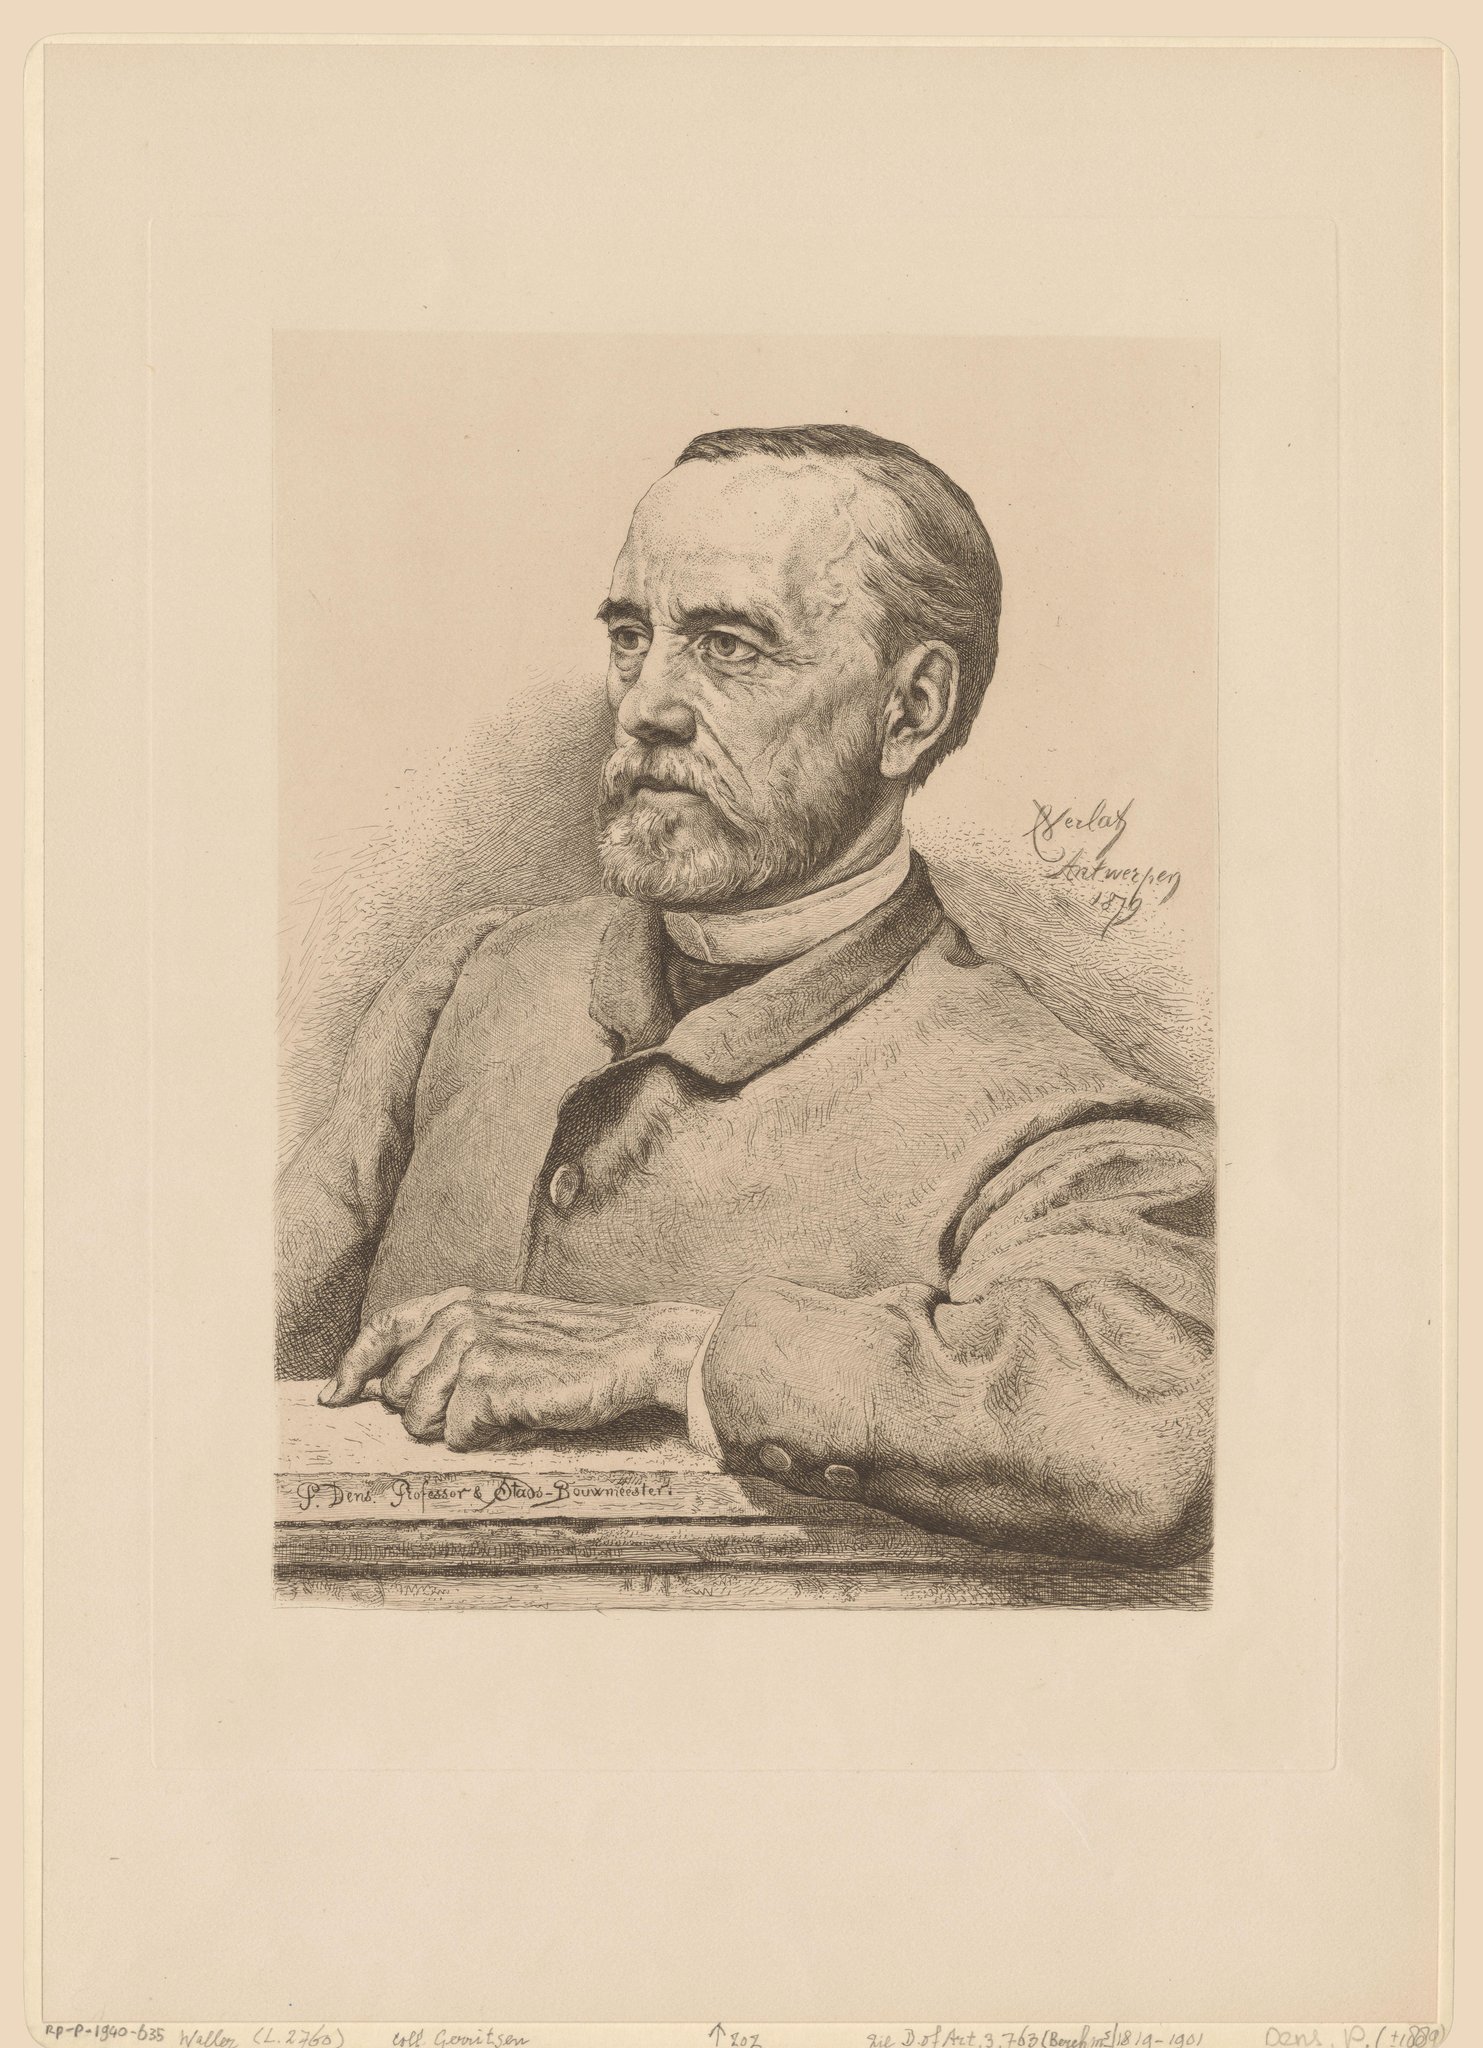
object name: print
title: Portret van Pierre Dens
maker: charles verlat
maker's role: painter, print maker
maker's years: 1824-1890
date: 1879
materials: paper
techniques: etching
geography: antwerp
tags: pierre dens, historical persons, portrait, self-portrait of architect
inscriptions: collector's mark: Lugt 2760, collector's mark: Lugt 2228